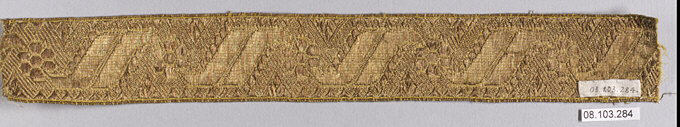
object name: galloon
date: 1601-1800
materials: metal thread